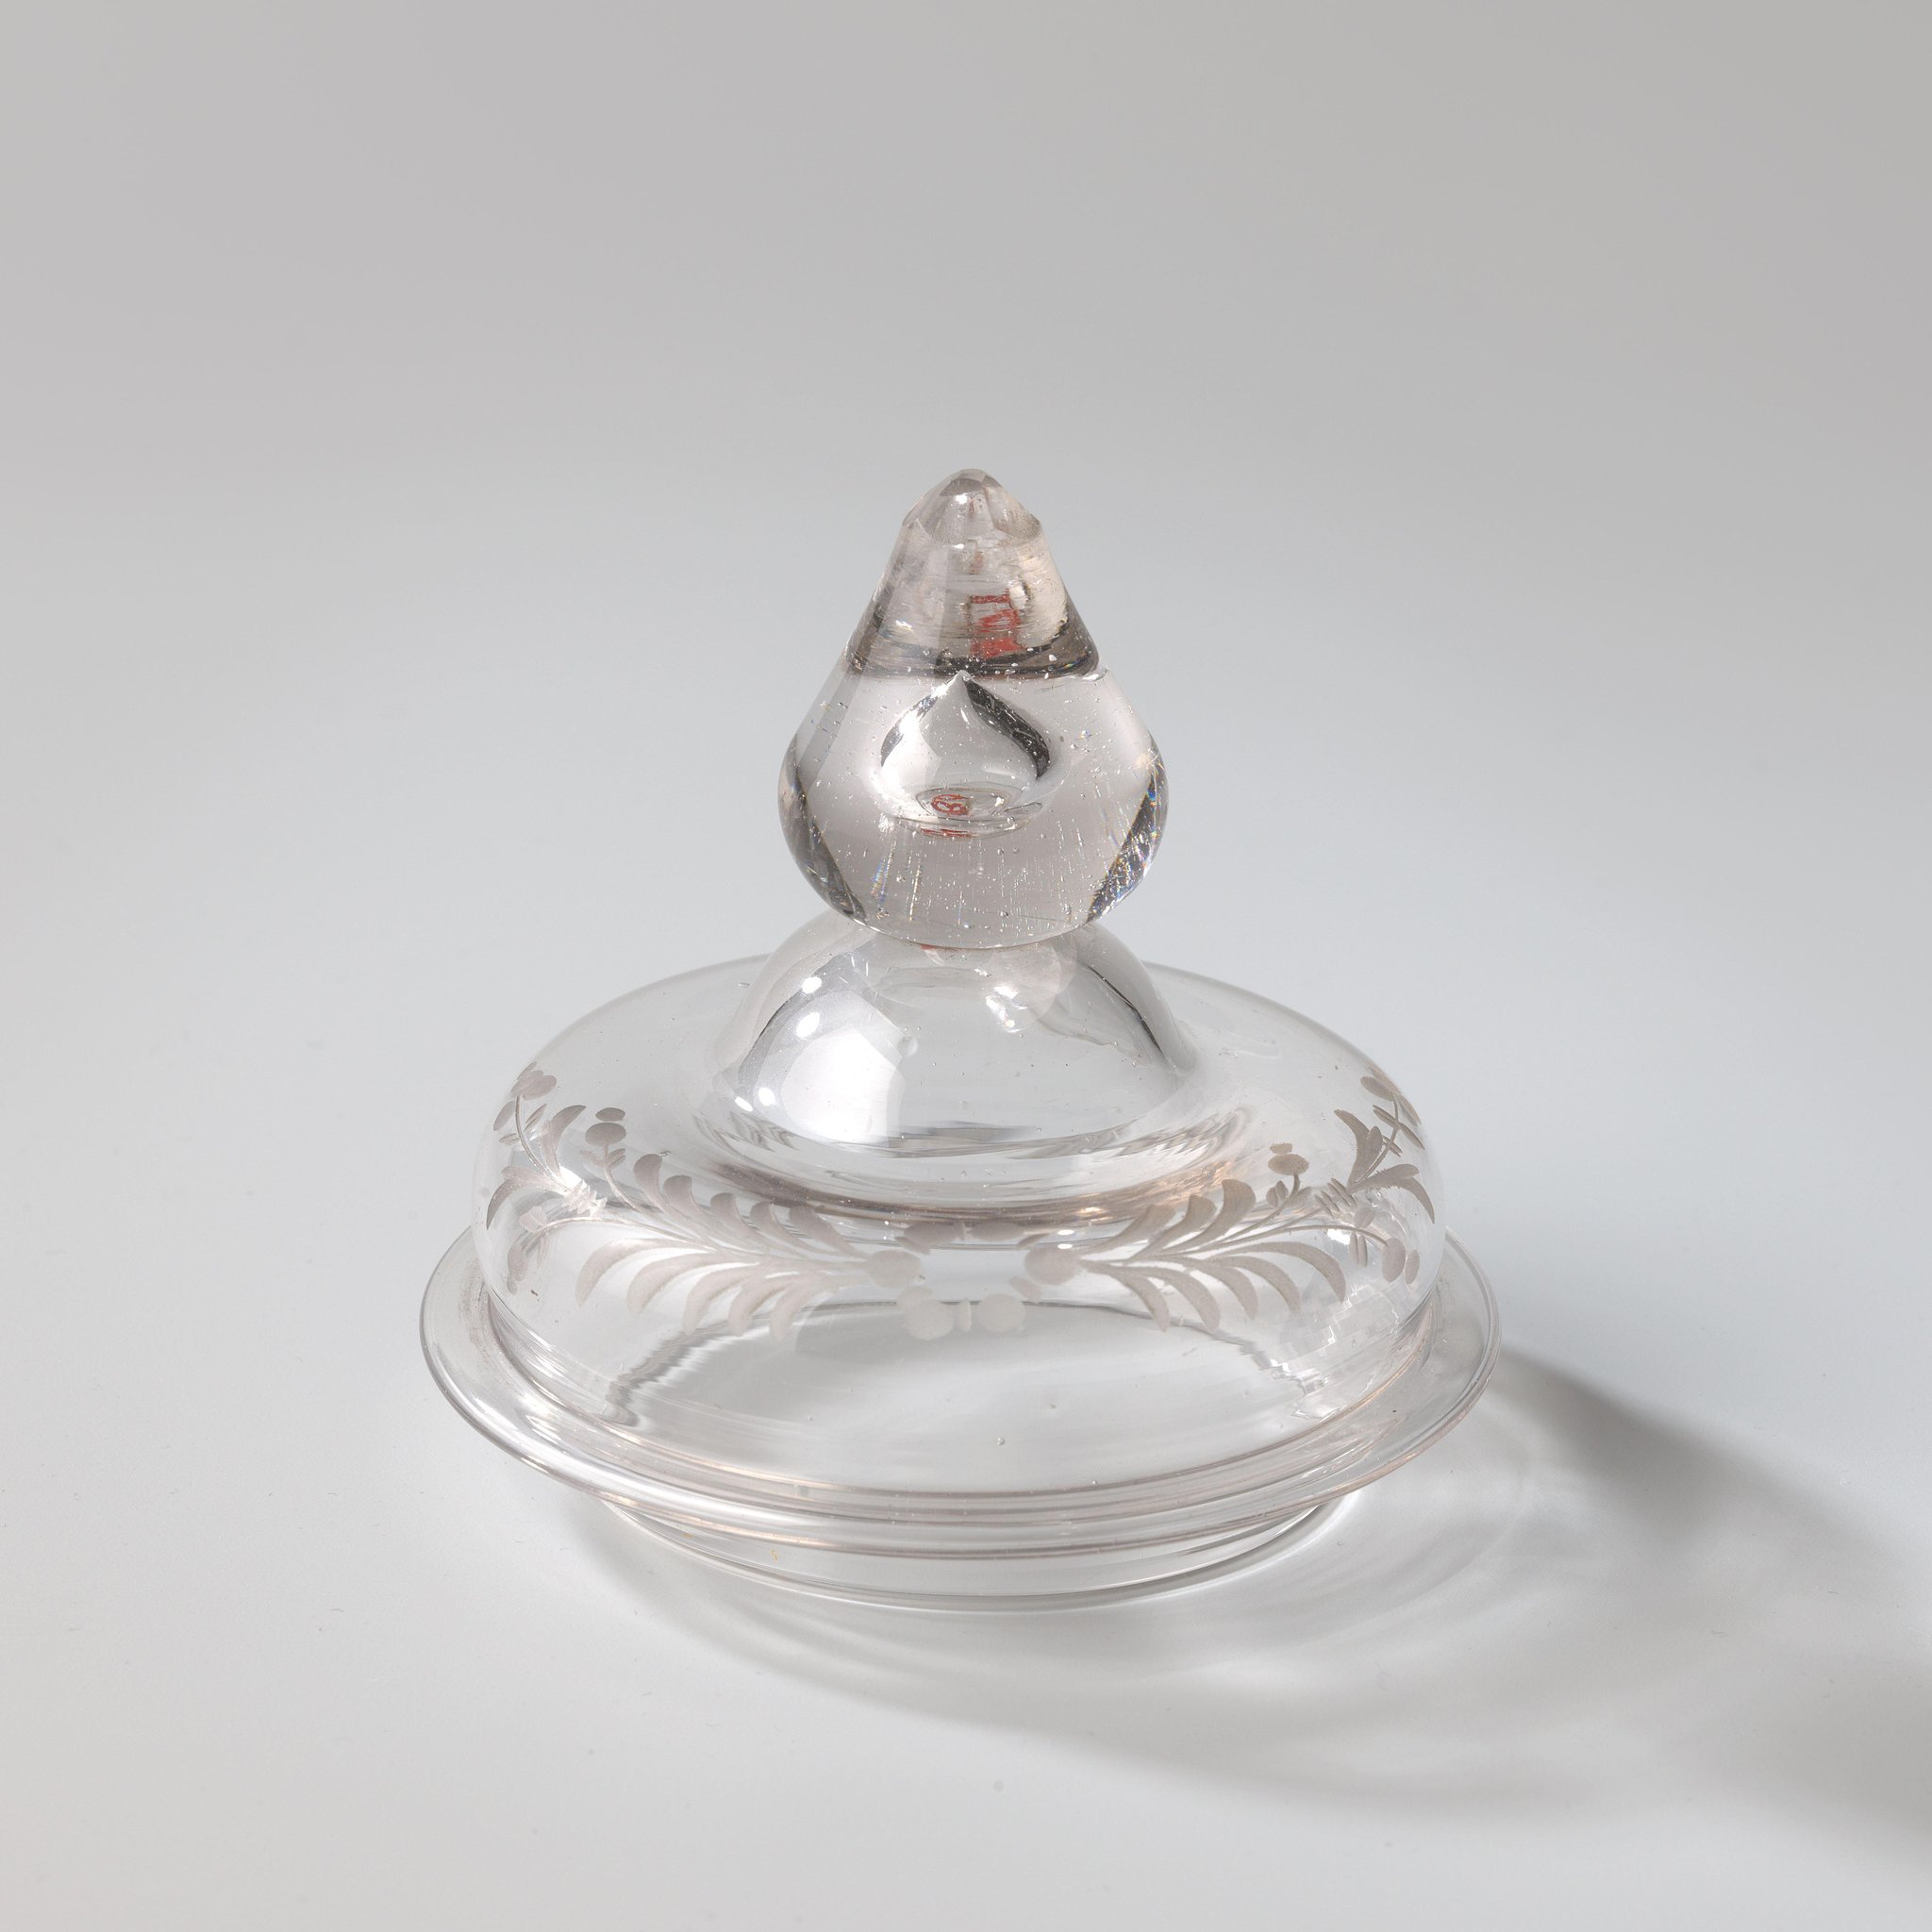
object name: lid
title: Deksel van bokaal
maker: Anonymous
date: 1725-1750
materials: glass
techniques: glassblowing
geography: northern netherlands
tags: verenigde oostindische compagnie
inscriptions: inscription: ‘T.WELVAAREN.VAN.DEOOSTINDISCHE.COMPAGNIE’